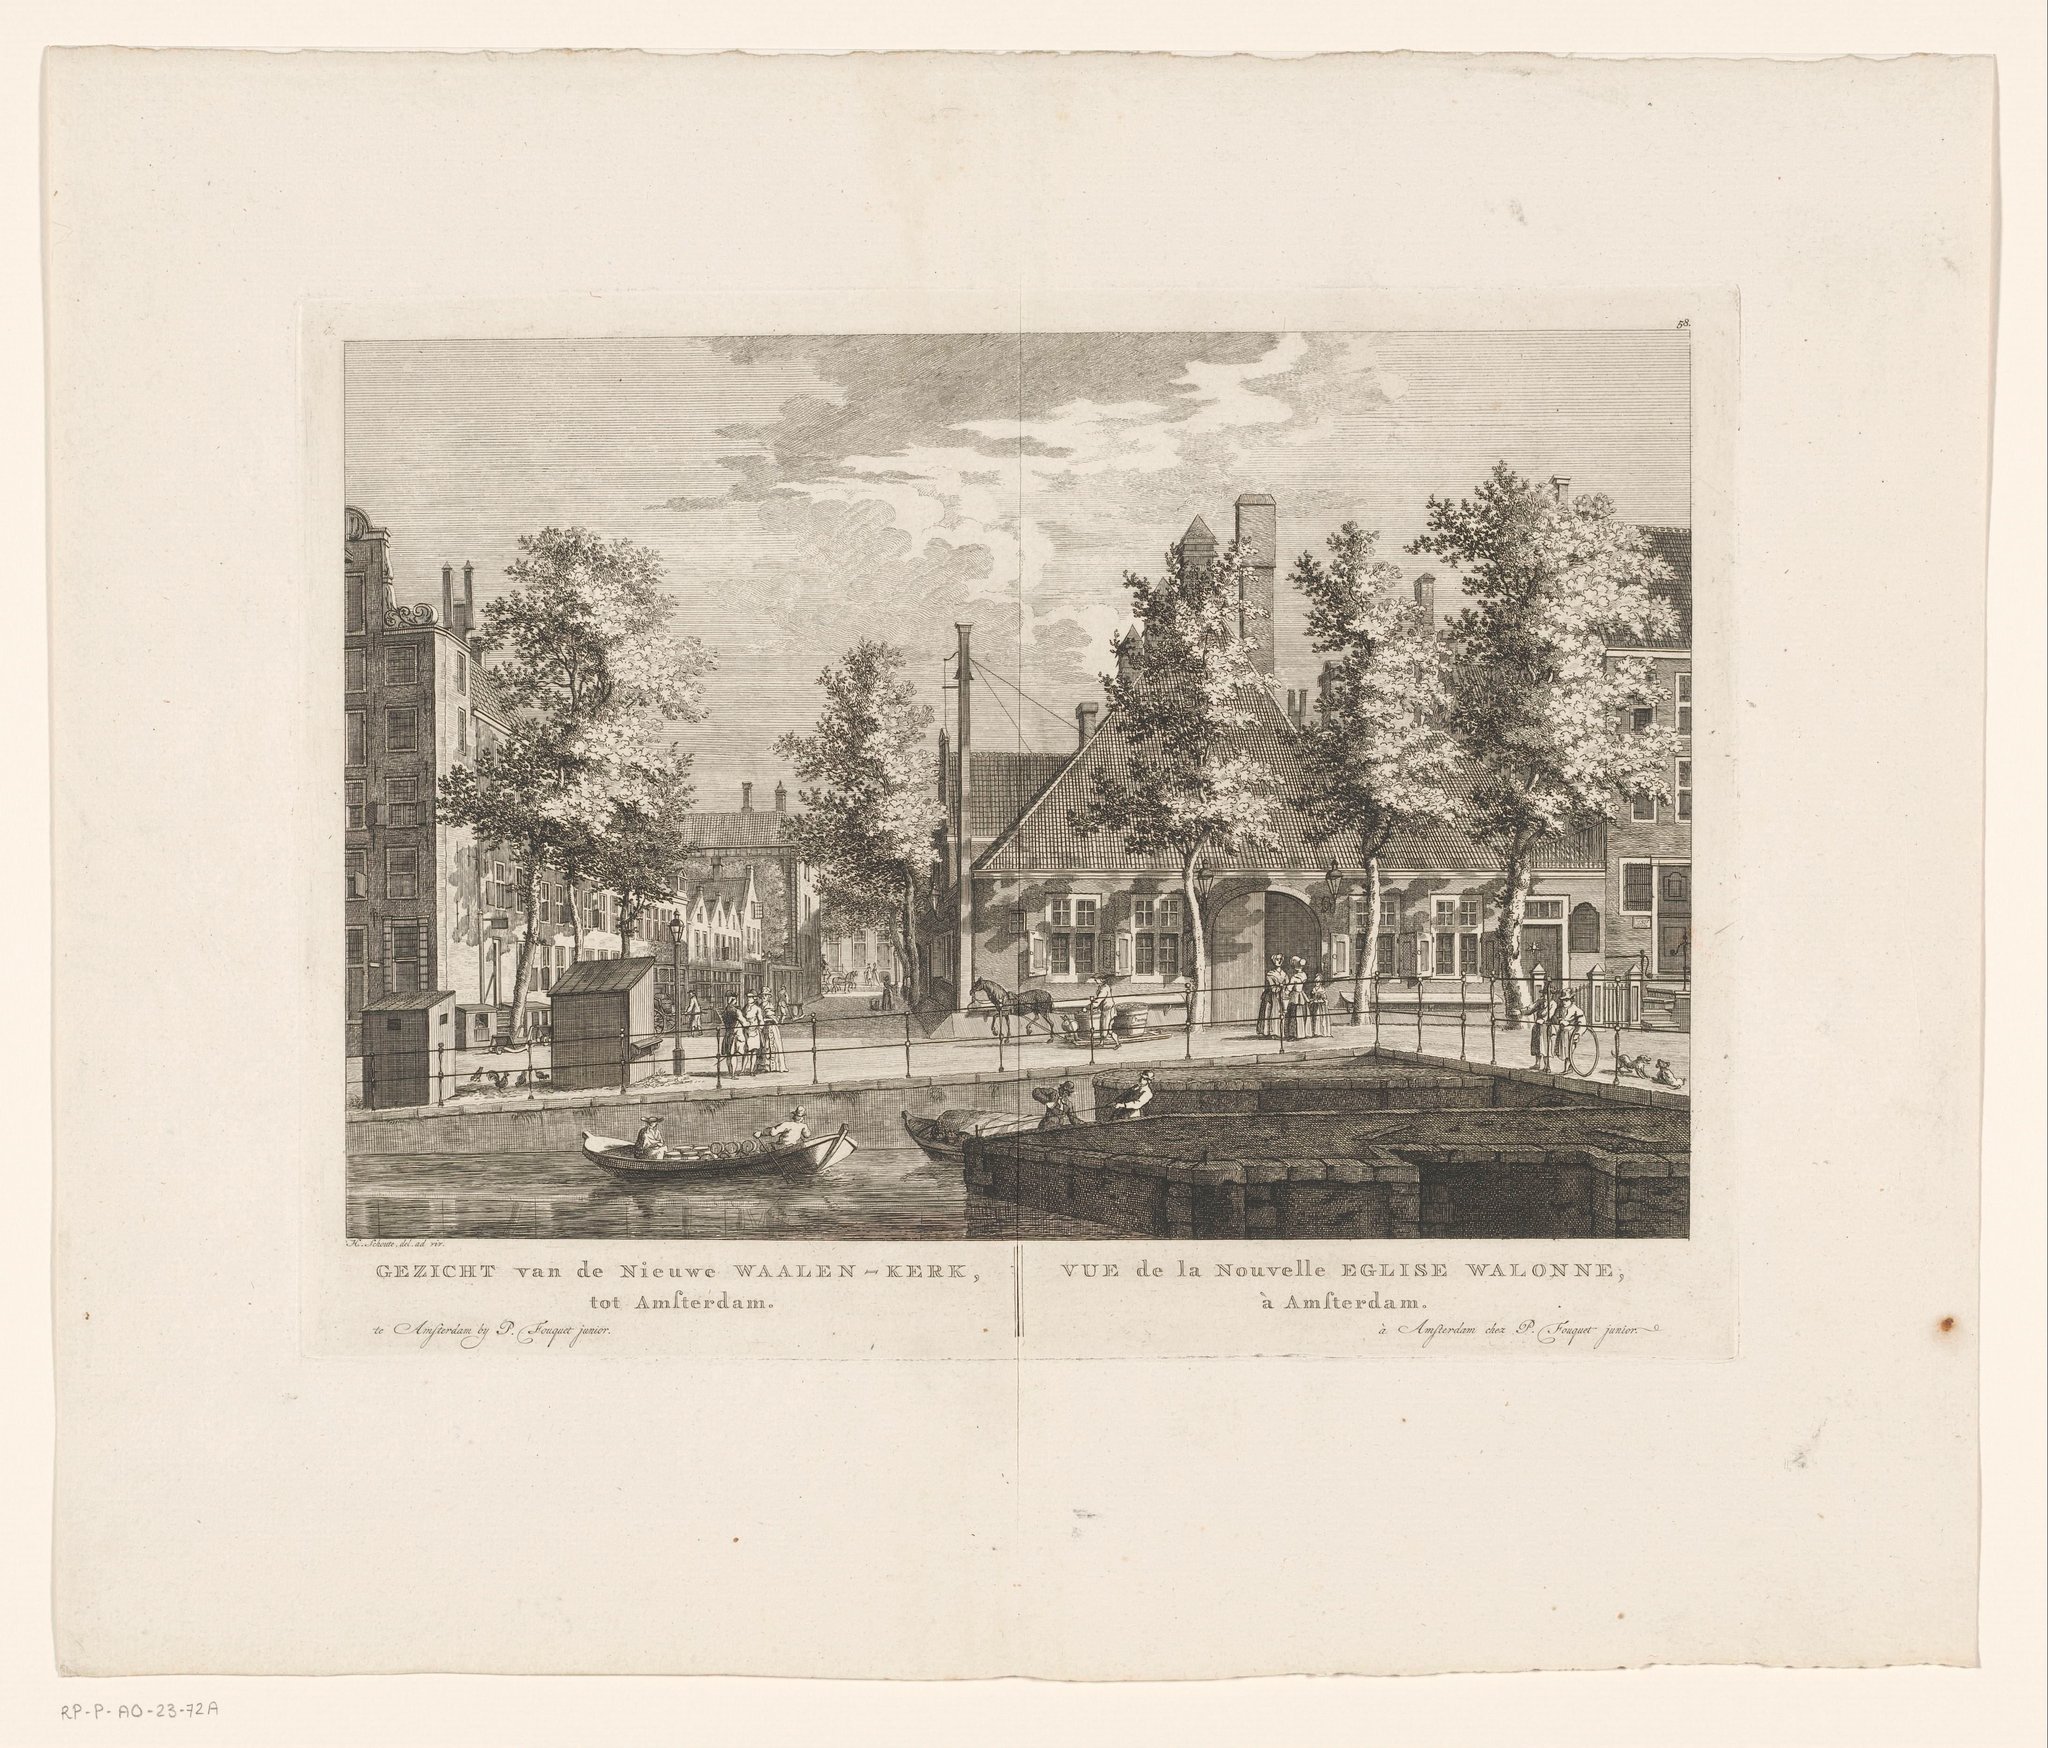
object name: print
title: Gezicht van de Nieuwe Waalen-Kerk, tot Amsterdam / Vue de la Nouvelle Eglise Walonne, à Amsterdam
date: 1770-1783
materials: paper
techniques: engraving, etching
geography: amsterdam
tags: sluice, weir, bridge in city across river, canal, etc. (+ city(-scape) with figures, staffage), church (exterior), street (+ city(-scape) with figures, staffage)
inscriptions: collector's mark: Lugt 2228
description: Deze prent is ook gebruikt in de zogenaamde Atlas van Fouquet.* Pierre Fouquet gaf vanaf 1760 stadsgezichten van Amsterdam - naar tekeningen van verschillende kunstenaars, gemaakt door verschillende prentmakers - uit. Deze prenten werden aanvankelijk los of in series verkocht. Zoals toen gebruikelijk kon de koper de prenten zelf laten inbinden. Hiertoe gaf Fouquet tussen 1778 en 1783 een titelblad, plattegrond en inhoudsopgave van de tot dusver 100 uitgegeven prenten uit (1). Gezien de inhoud afhankelijk was van wat de koper had verzameld verschilt de inhoud van de verschillende bewaarde Fouquetatlassen onder deze titel sterk. Ook zijn er exemplaren bekend waar tevens andere prenten aan zijn toegevoegd. Omdat er behoefte bleek aan uitleg bij de platen werd in 1783 een nieuwe versie van de atlas uitgegeven, aangevuld met tekst en twee prenten. De aangegeven volgorde veranderde maar de platen van de al eerder uitgegeven prenten bleven ongewijzigd. Deze uitgave werd in opdracht van Fouquet gedrukt bij Daniël Jean Changuion en Petrus den Hengst (2). Een tiental platen werd bijgewerkt en verscheen, met nieuw impressum, in het vervolg van Wagenaars geschiedenis van Amsterdam, uitgeven door Petrus Conradi en Folkert van der Plaats (3). Een aantal jaar na het overlijden van Fouquet kwam Evert Maaskamp met een nieuwe uitgave van de atlas, met verbeterde tekst en toevoeging van twee prenten. Op alle platen verwijderde hij het oude en liet hij zijn eigen impressum zetten (4). De huidige staat van de prent komt voor in exemplaren van de onder (1) en (2) genoemde werken. * Onder de Atlas van Fouquet of Fouquetatlas verstaan we de hieronder vermelde publicaties (1), (2) en (4). (1). Afbeeldingen van de wyd-vermaarde koopstad Amsterdam benevens des zelvs voornaamste gebouwen en gezigten alle naar het leeven getekend / Receuil des edifices les plus considerables et des plus belles vues, de la fameuse ville d'Amsterdam, dessinées d'après nature. Amsterdam: Pierre Fouquet, 1778-1783. (2). Nieuwe atlas, van de voornaamste gebouwen en gezigten der stad Amsterdam, met derzelver beknopte beschryvingen. 2 delen. Amsterdam: Daniël Jean Changuion en Petrus den Hengst [in opdracht van Pierre Fouquet], 1783. (3). Stijl, Simon. Amsterdam, in zyne geschiedenissen, voorregten, koophandel, gebouwen, kerkenstaat, schoolen, schutterye, gilden en regeeringe, beschreeven. Om te dienen ten vervolge op het werk van Jan Wagenaar (…). 10 delen. Amsterdam en Harlingen: Petrus Conradi en Folkert van der Plaats, 1788-1801. (4). Nieuwe atlas, van de voornaamste gebouwen en gezigten der stad Amsterdam. Met derzelver beknopte beschryvingen. Amsterdam: Evert Maaskamp, 1805. * Het aantal vermelde staten is gebaseerd op het aantal gevonden staten. Mogelijk zijn er meer staten van deze prent. Zie RP-P-1998-765 voor derde bekende staat.